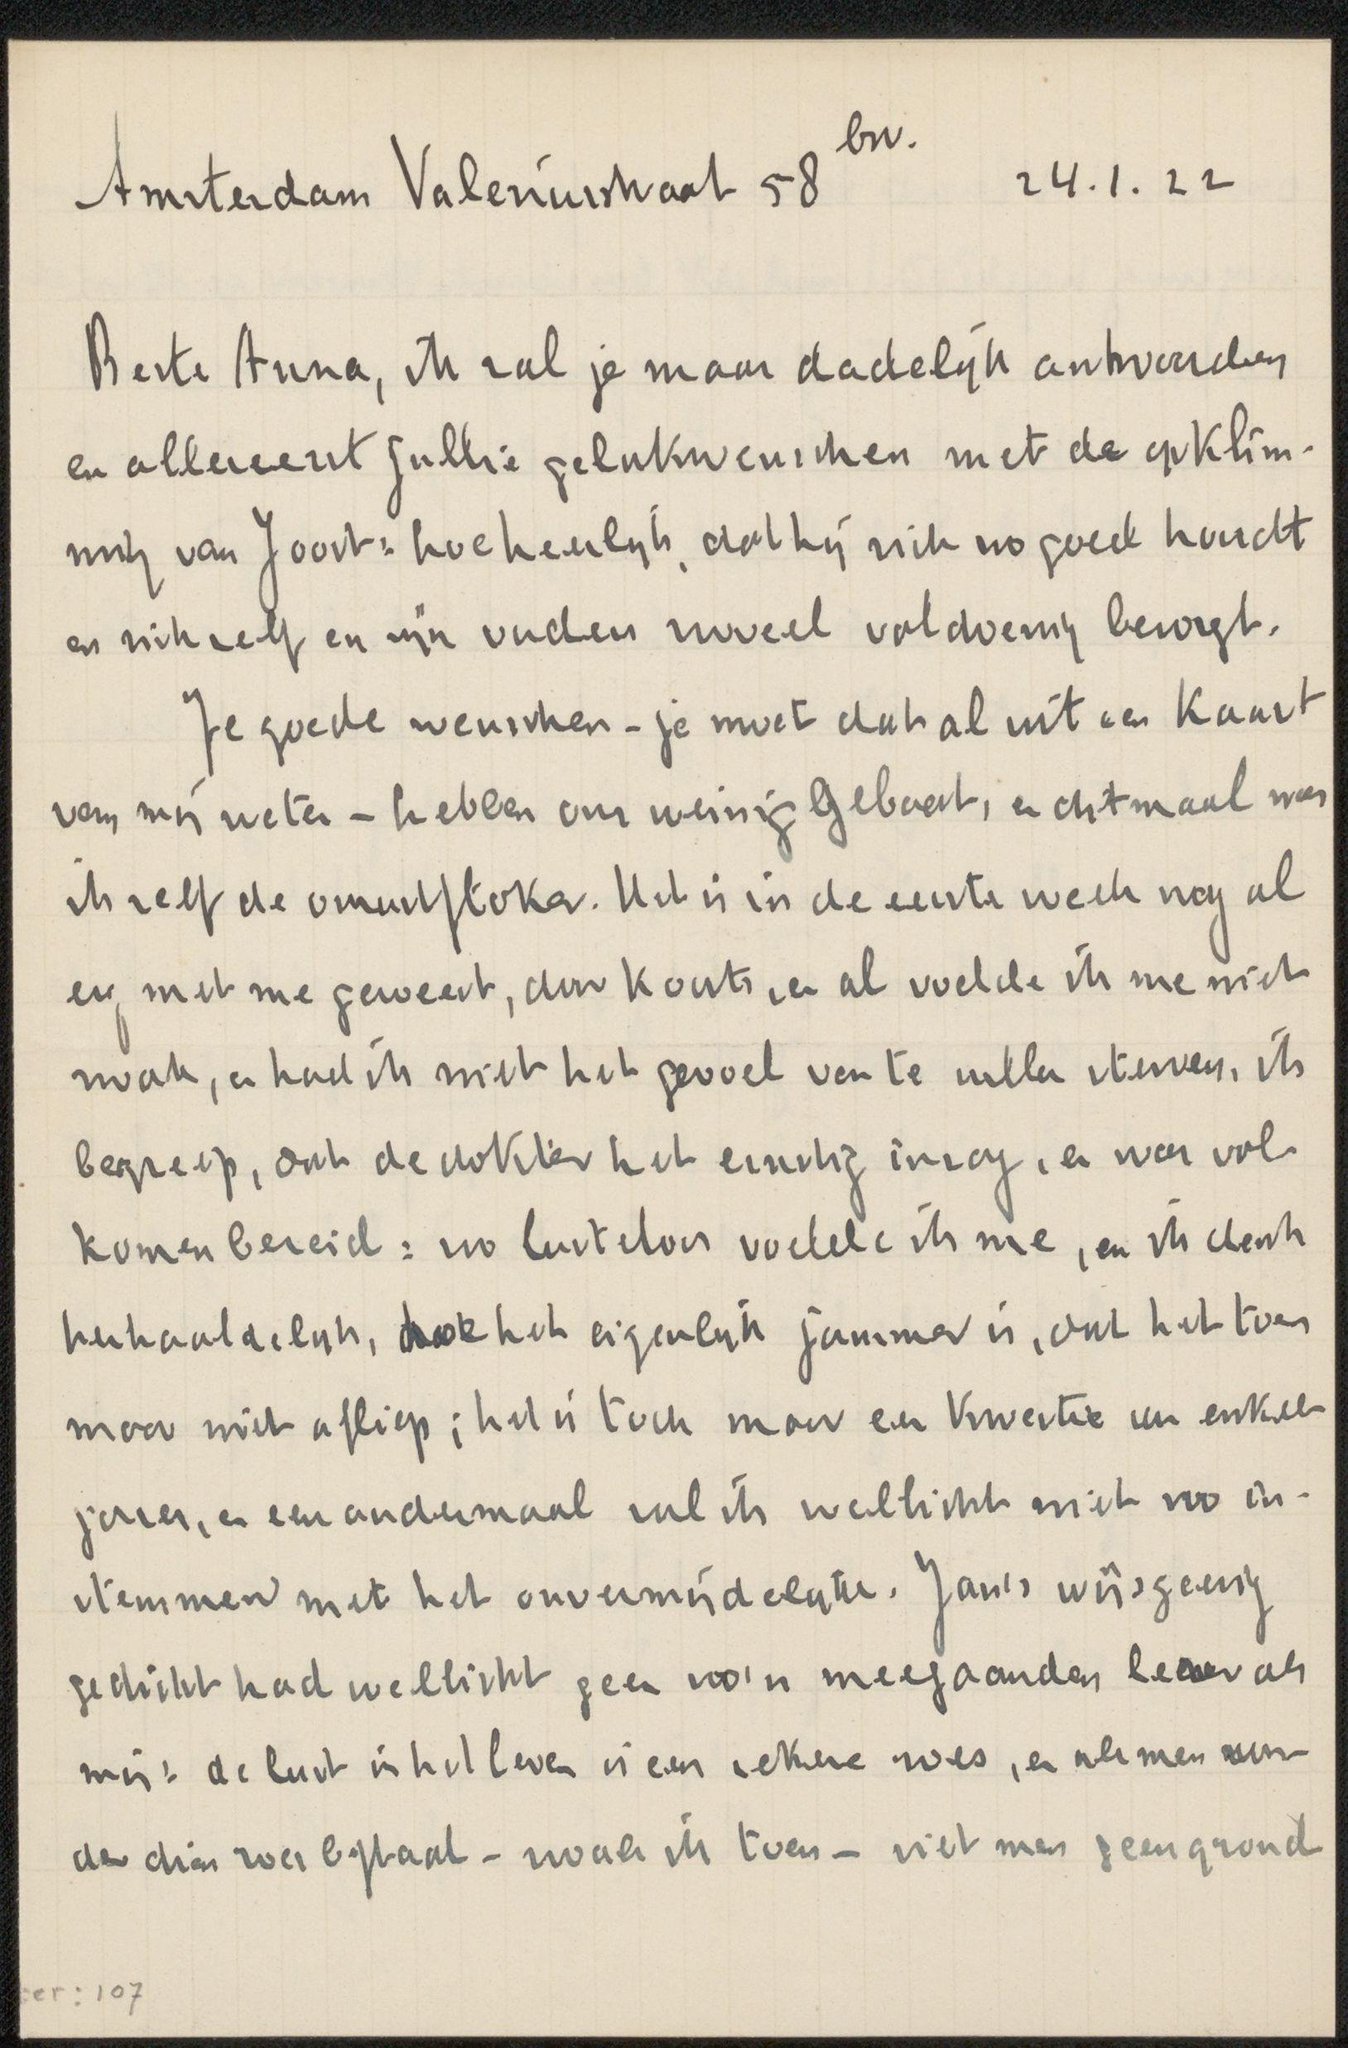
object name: letter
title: Brief aan Anna Dorothea Dirks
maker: chap van deventer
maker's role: kunstcriticus, scheikundige, schrijver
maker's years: 1860-1931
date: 1922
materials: ink, paper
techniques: pen, writing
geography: amsterdam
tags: rotterdam, george hendrik breitner, designer, jan veth, painter, print maker, draughtsman, willem witsen, artist, anna dorothea dirks, haarlem, paris, gideon busken huet, catharina henriette perk, anonymous historical person portrayed, diseases, java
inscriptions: collector's mark: ‘RPK’